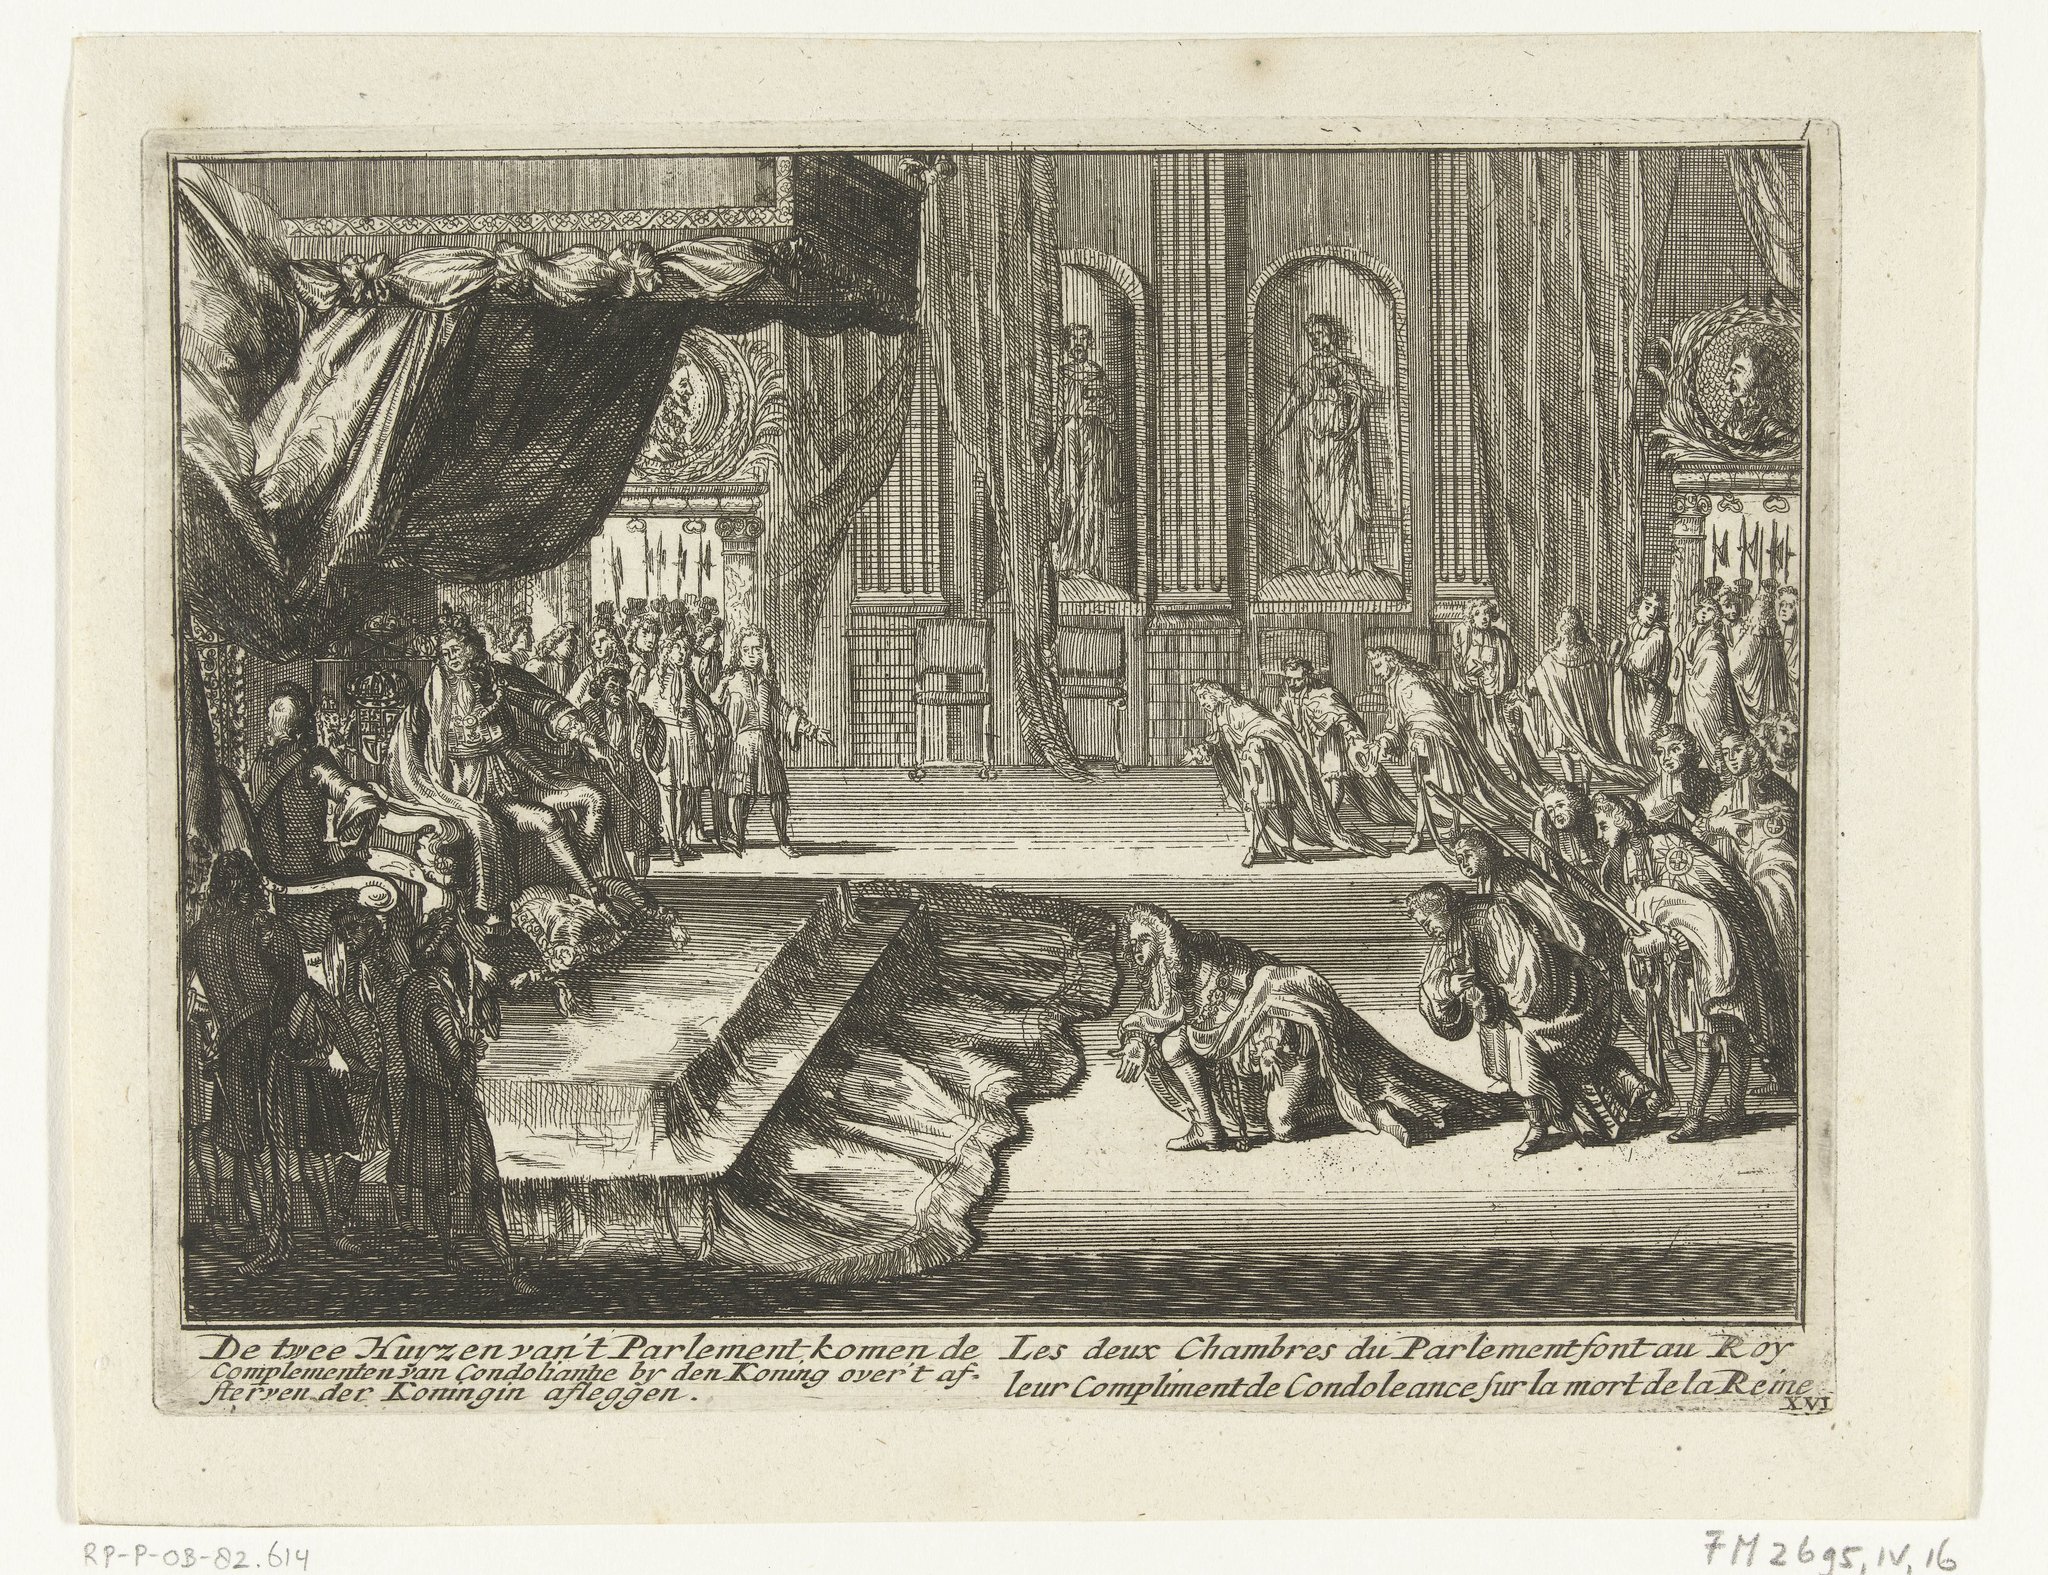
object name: print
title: Engelands Schoutoneel, verbeeldende 't Gedenckwaardigste in en ontrent Engeland, Yerland, Vrankryk en de Nederlanden voorgevallen, zedert 't Jaar 1692, tot het Begraven der Koninginne Maria de tweede, 1695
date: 1695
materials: paper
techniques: etching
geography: northern netherlands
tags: the hague, william iii (prince of orange and king of england, scotland, and ireland), london, maria ii stuart (koningin van engeland, schotland en ierland), condolence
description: De leden van het Hogerhuis en Lagerhuis van het Engelse parlement condoleren koning Willem III na het overlijden van de koningin Maria II Stuart op 7 januari 1695. Links de koning op zijn troon. Plaat nr. XVI in de serie 'Engelands schouwtoneel' over oorlogen gevoerd door Willem III in de jaren 1691-1695 na de Glorious Revolution, (vierde deel). Met onderschriften in het Nederlands en Frans.